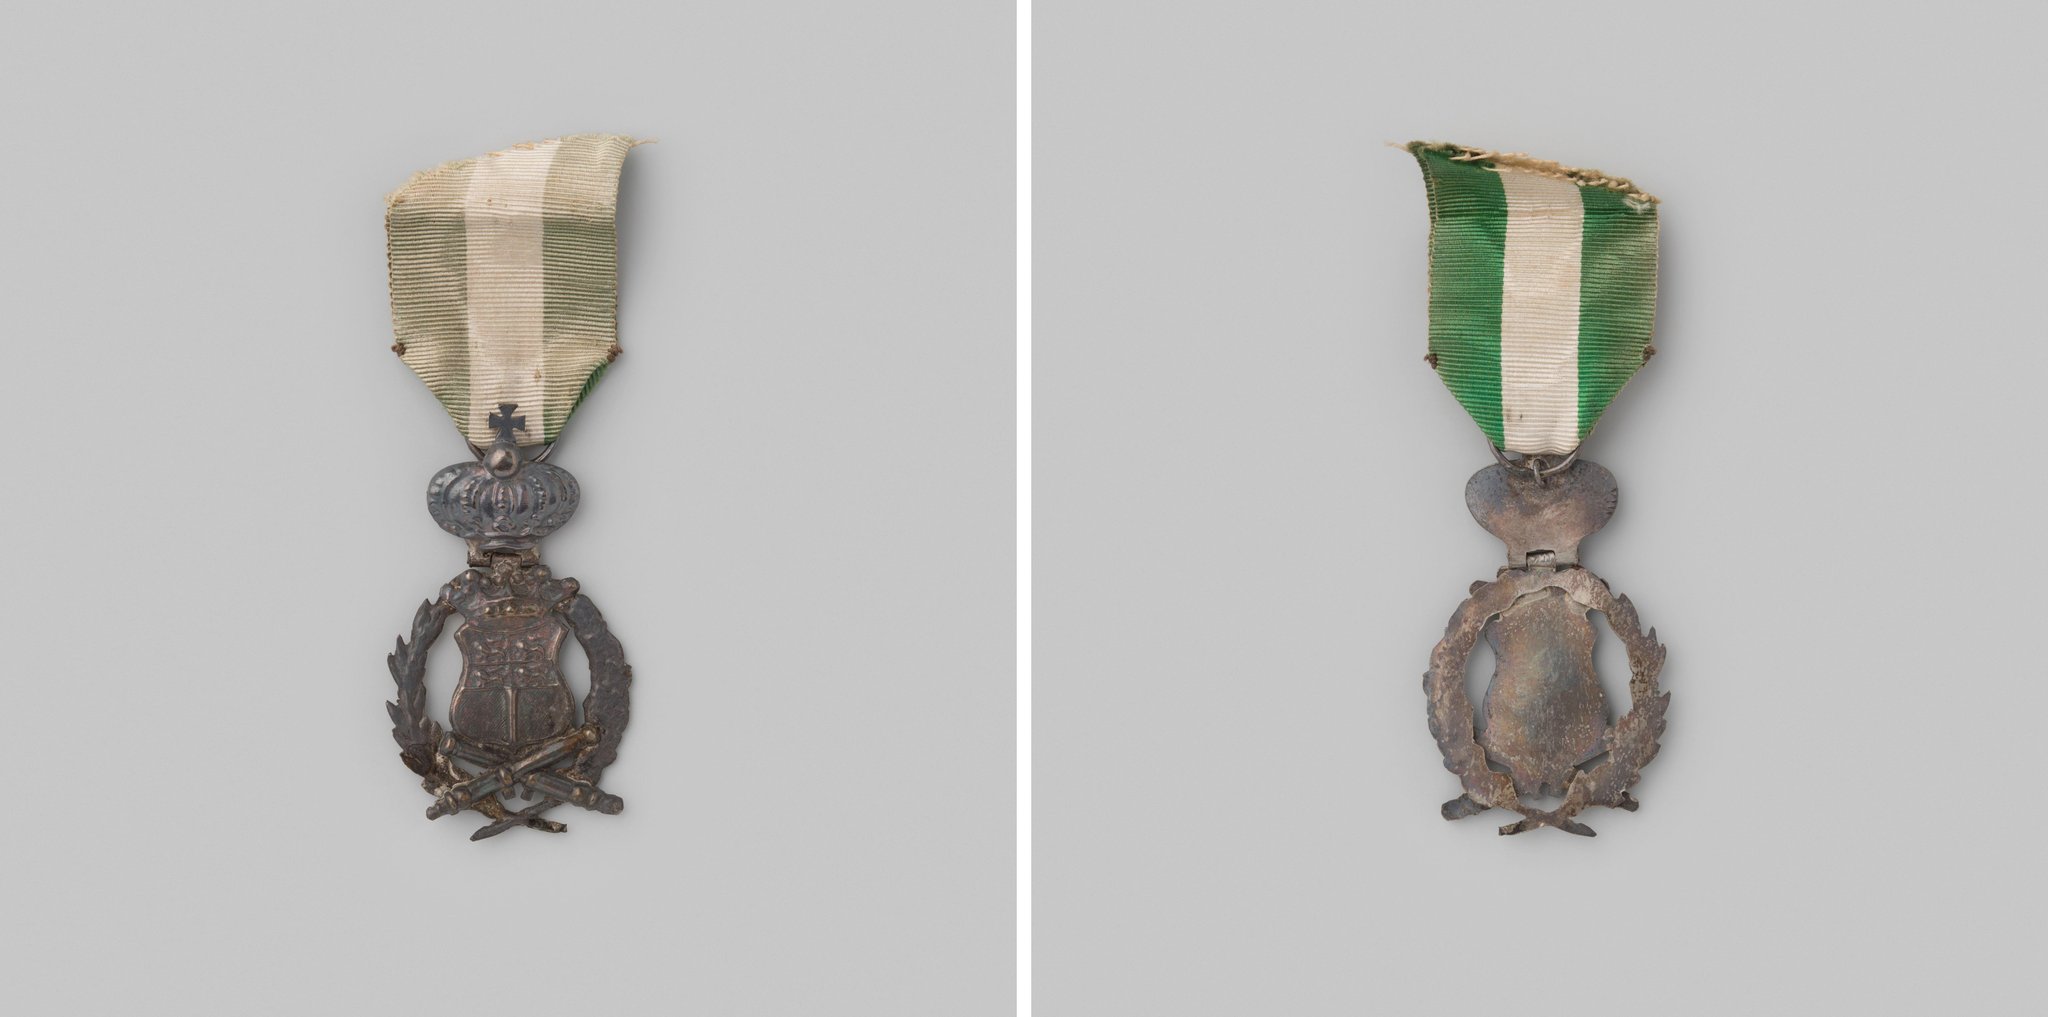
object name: insignia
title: Draagteken van de Koninklijke vereeniging Het Metalen Kruis, afdeling Rotterdam 2e sectie, opgericht 24 september 1857, in 1871 met predicaat koninklijk, uitgereikt aan kapitein oud-commandant der schutterij te Brielle M. van der Lugt Melsert in 1873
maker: Anonymous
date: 1857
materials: silver, textile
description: Zilveren draagteken, scharnier met kroon, oog, ring en lint